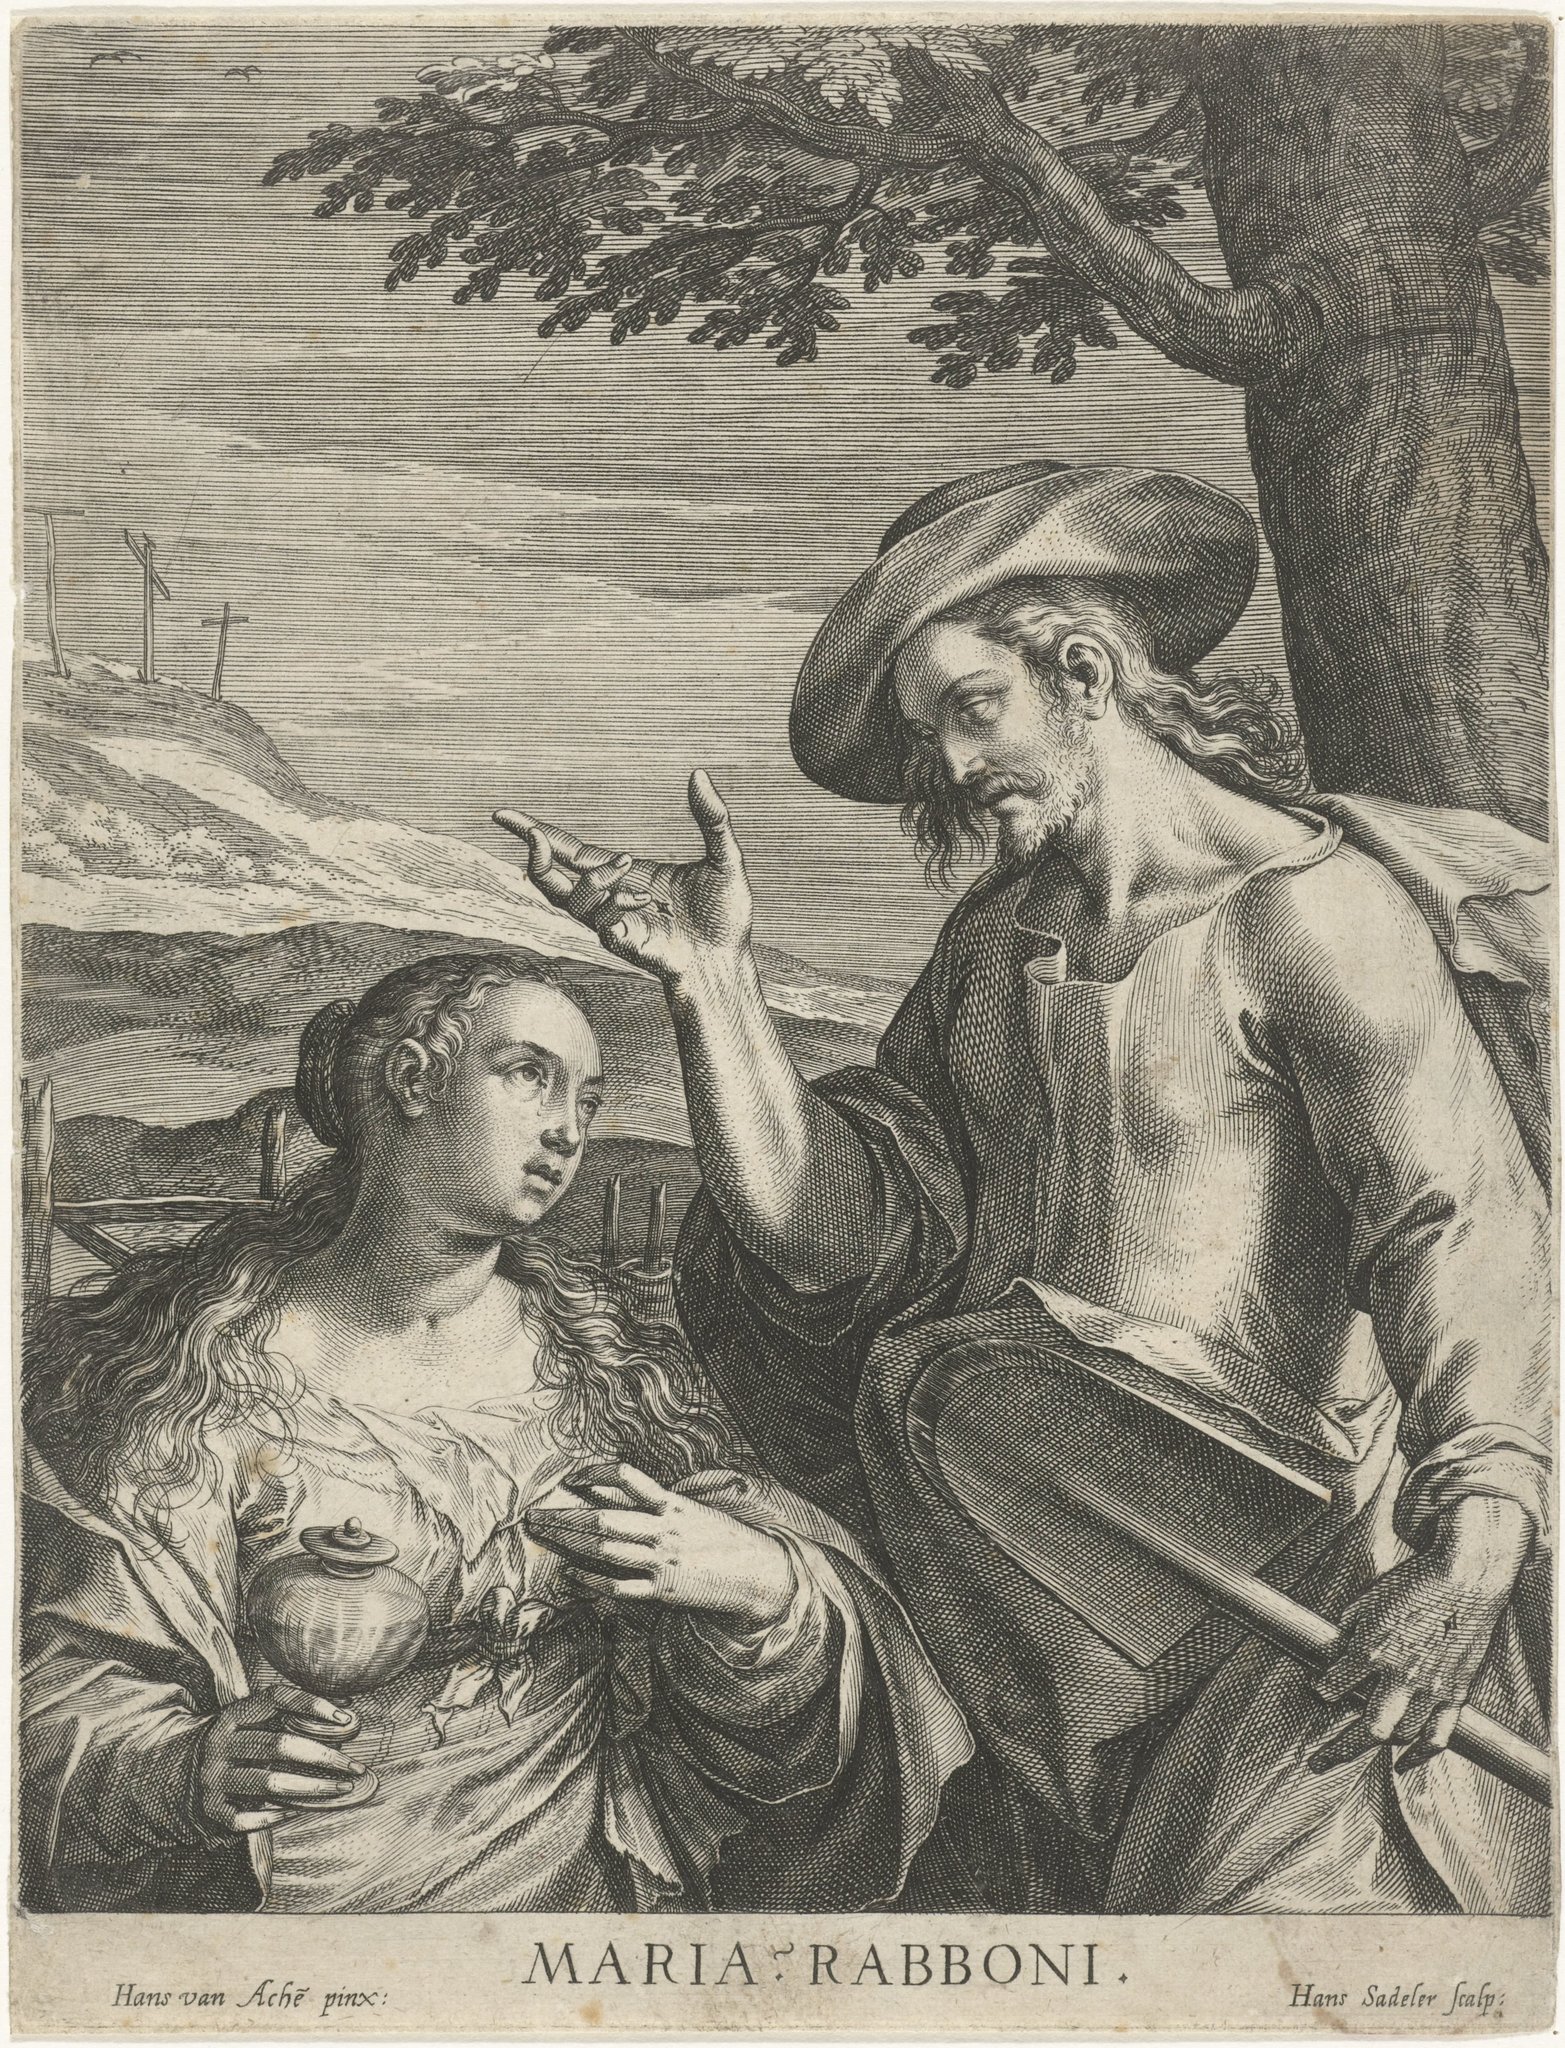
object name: print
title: Christus verschijnt als tuinman aan Maria Magdalena (Noli me tangere)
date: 1560-1600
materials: paper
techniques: engraving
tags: mary magdalene kneeling before christ, who is usually represented as a gardener with a hoe and/or a spade; 'noli me tangere'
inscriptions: collector's mark: Lugt 240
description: De verrezen Christus (rechts) verschijnt aan Maria Magdalena (links) in de gedaante van een tuinman. Maria Magdalena heeft een zalfpot in de hand. Op de achtergrond Golgota.